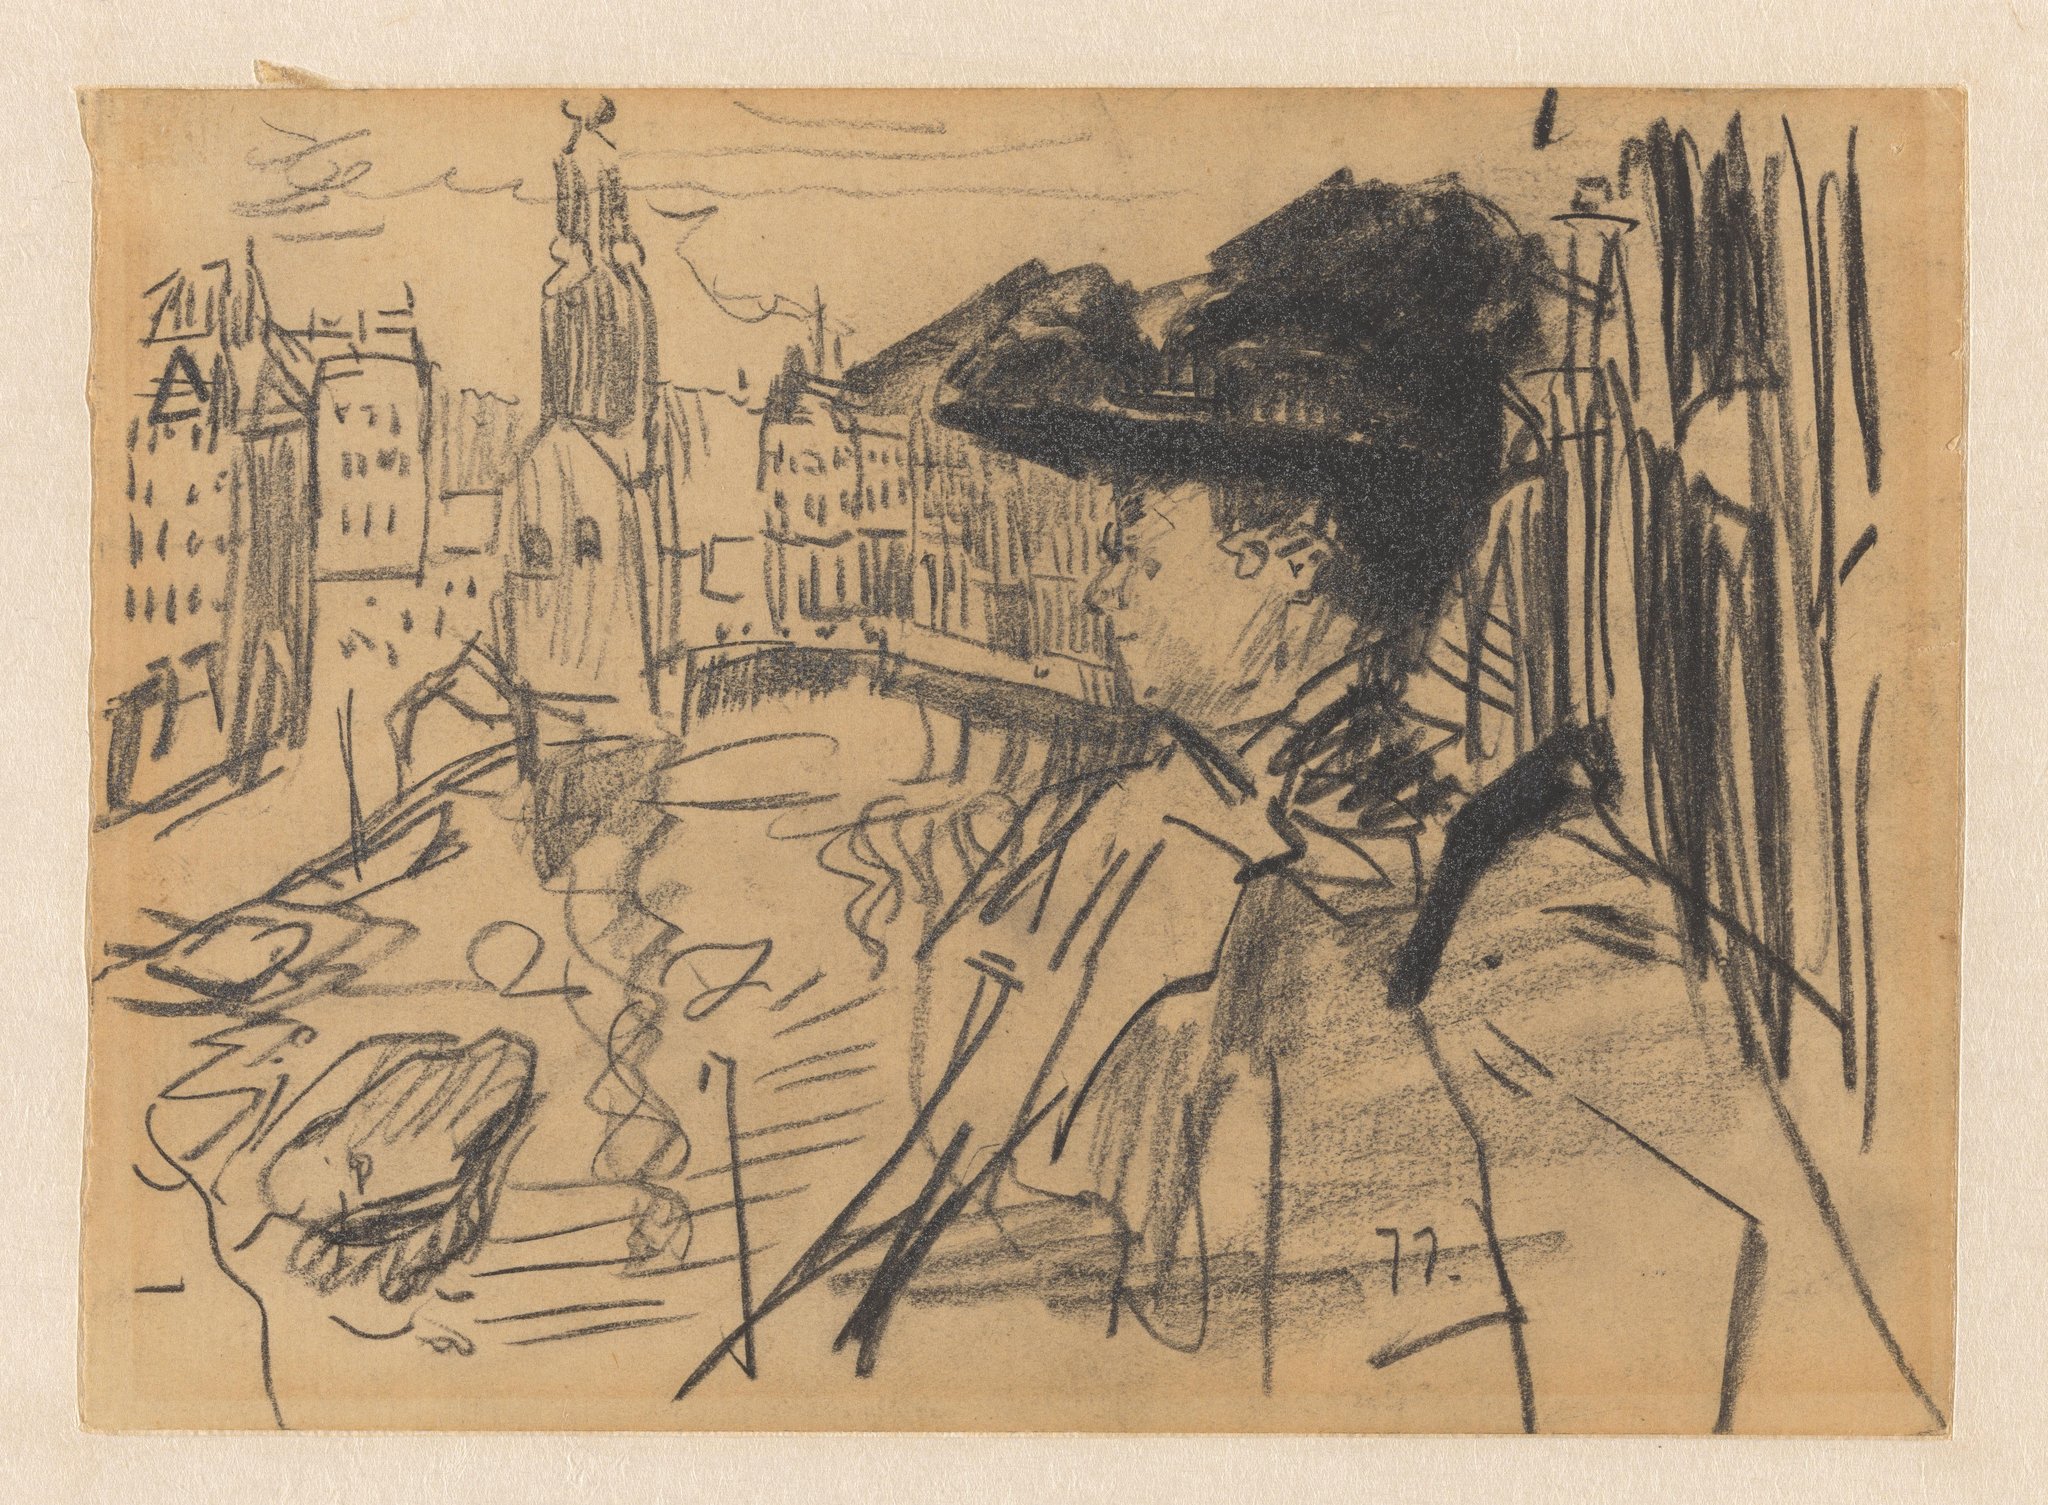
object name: drawing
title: The painter Thérèse Schwartze on a balcony overlooking the Singel in Amsterdam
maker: isaac israels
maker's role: draughtsman, painter, print maker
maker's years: 1865-1934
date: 1890-1895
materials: chalk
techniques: drawing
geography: amsterdam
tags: amsterdam, painter, print maker, draughtsman, thérèse schwartze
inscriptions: inscription: ‘Isaac Israëls tekende dit op balkon/ van het atelier Singel 514 naar mijn tante Therese/ Schwartz’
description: Een snel geschetst profiel van een vrouw met hoed, met op de linkerachtergrond de Singel en de Munttoren zichtbaar.